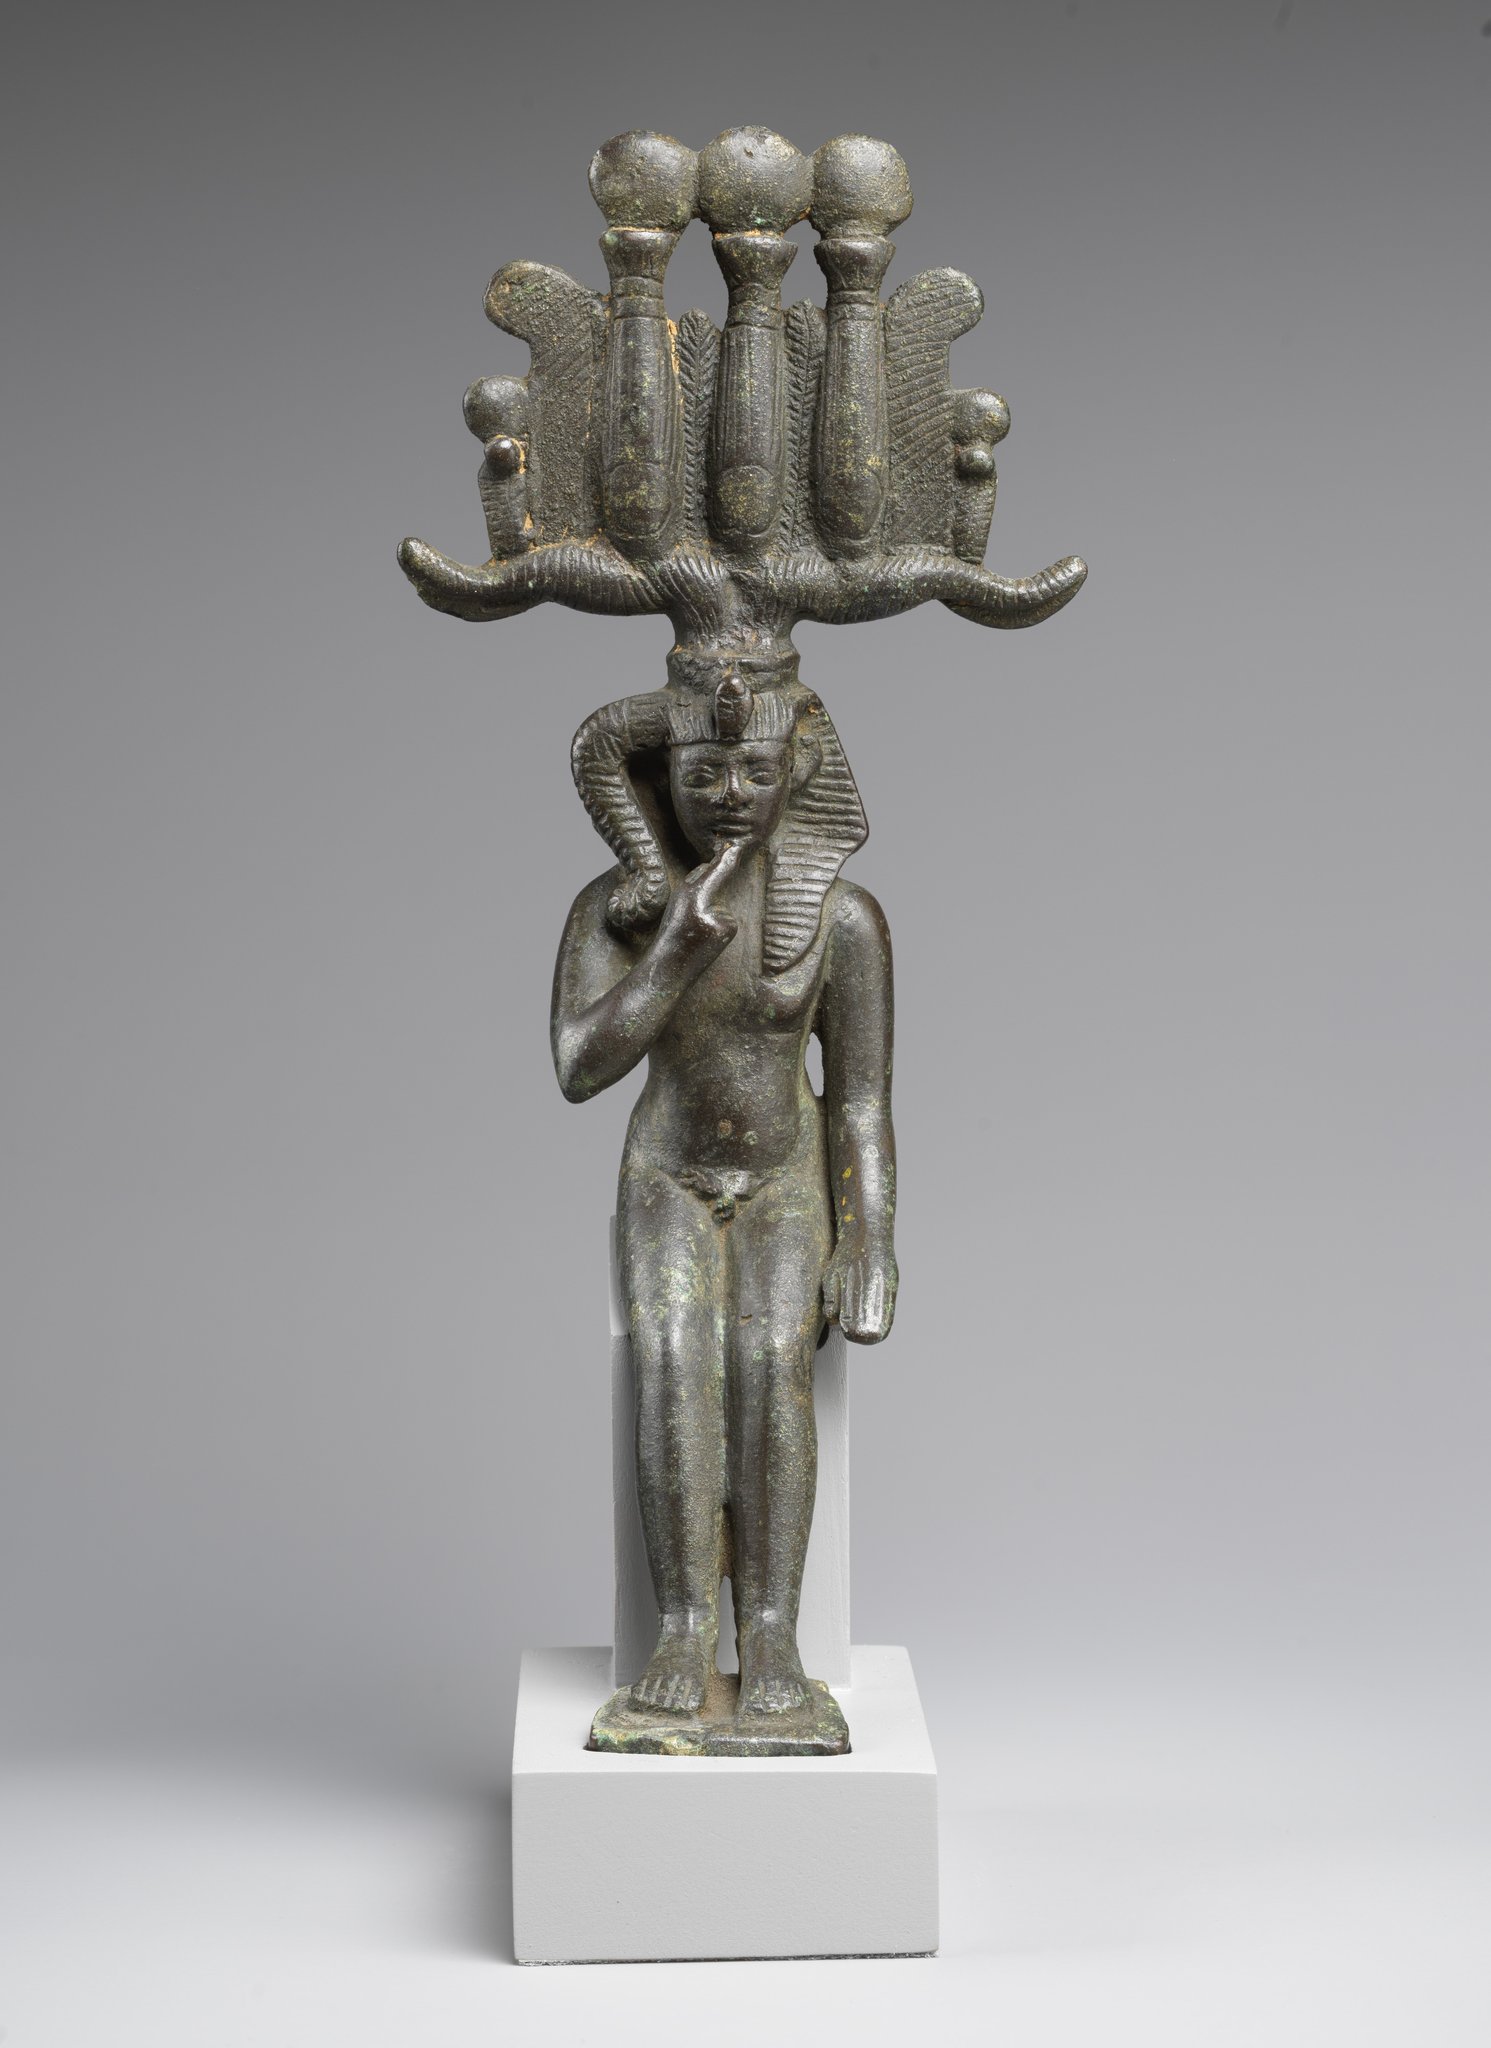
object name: statuette, child god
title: Child god in nemes and hemhem crown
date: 664-630 BCE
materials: metal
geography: egypt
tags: children,crowns